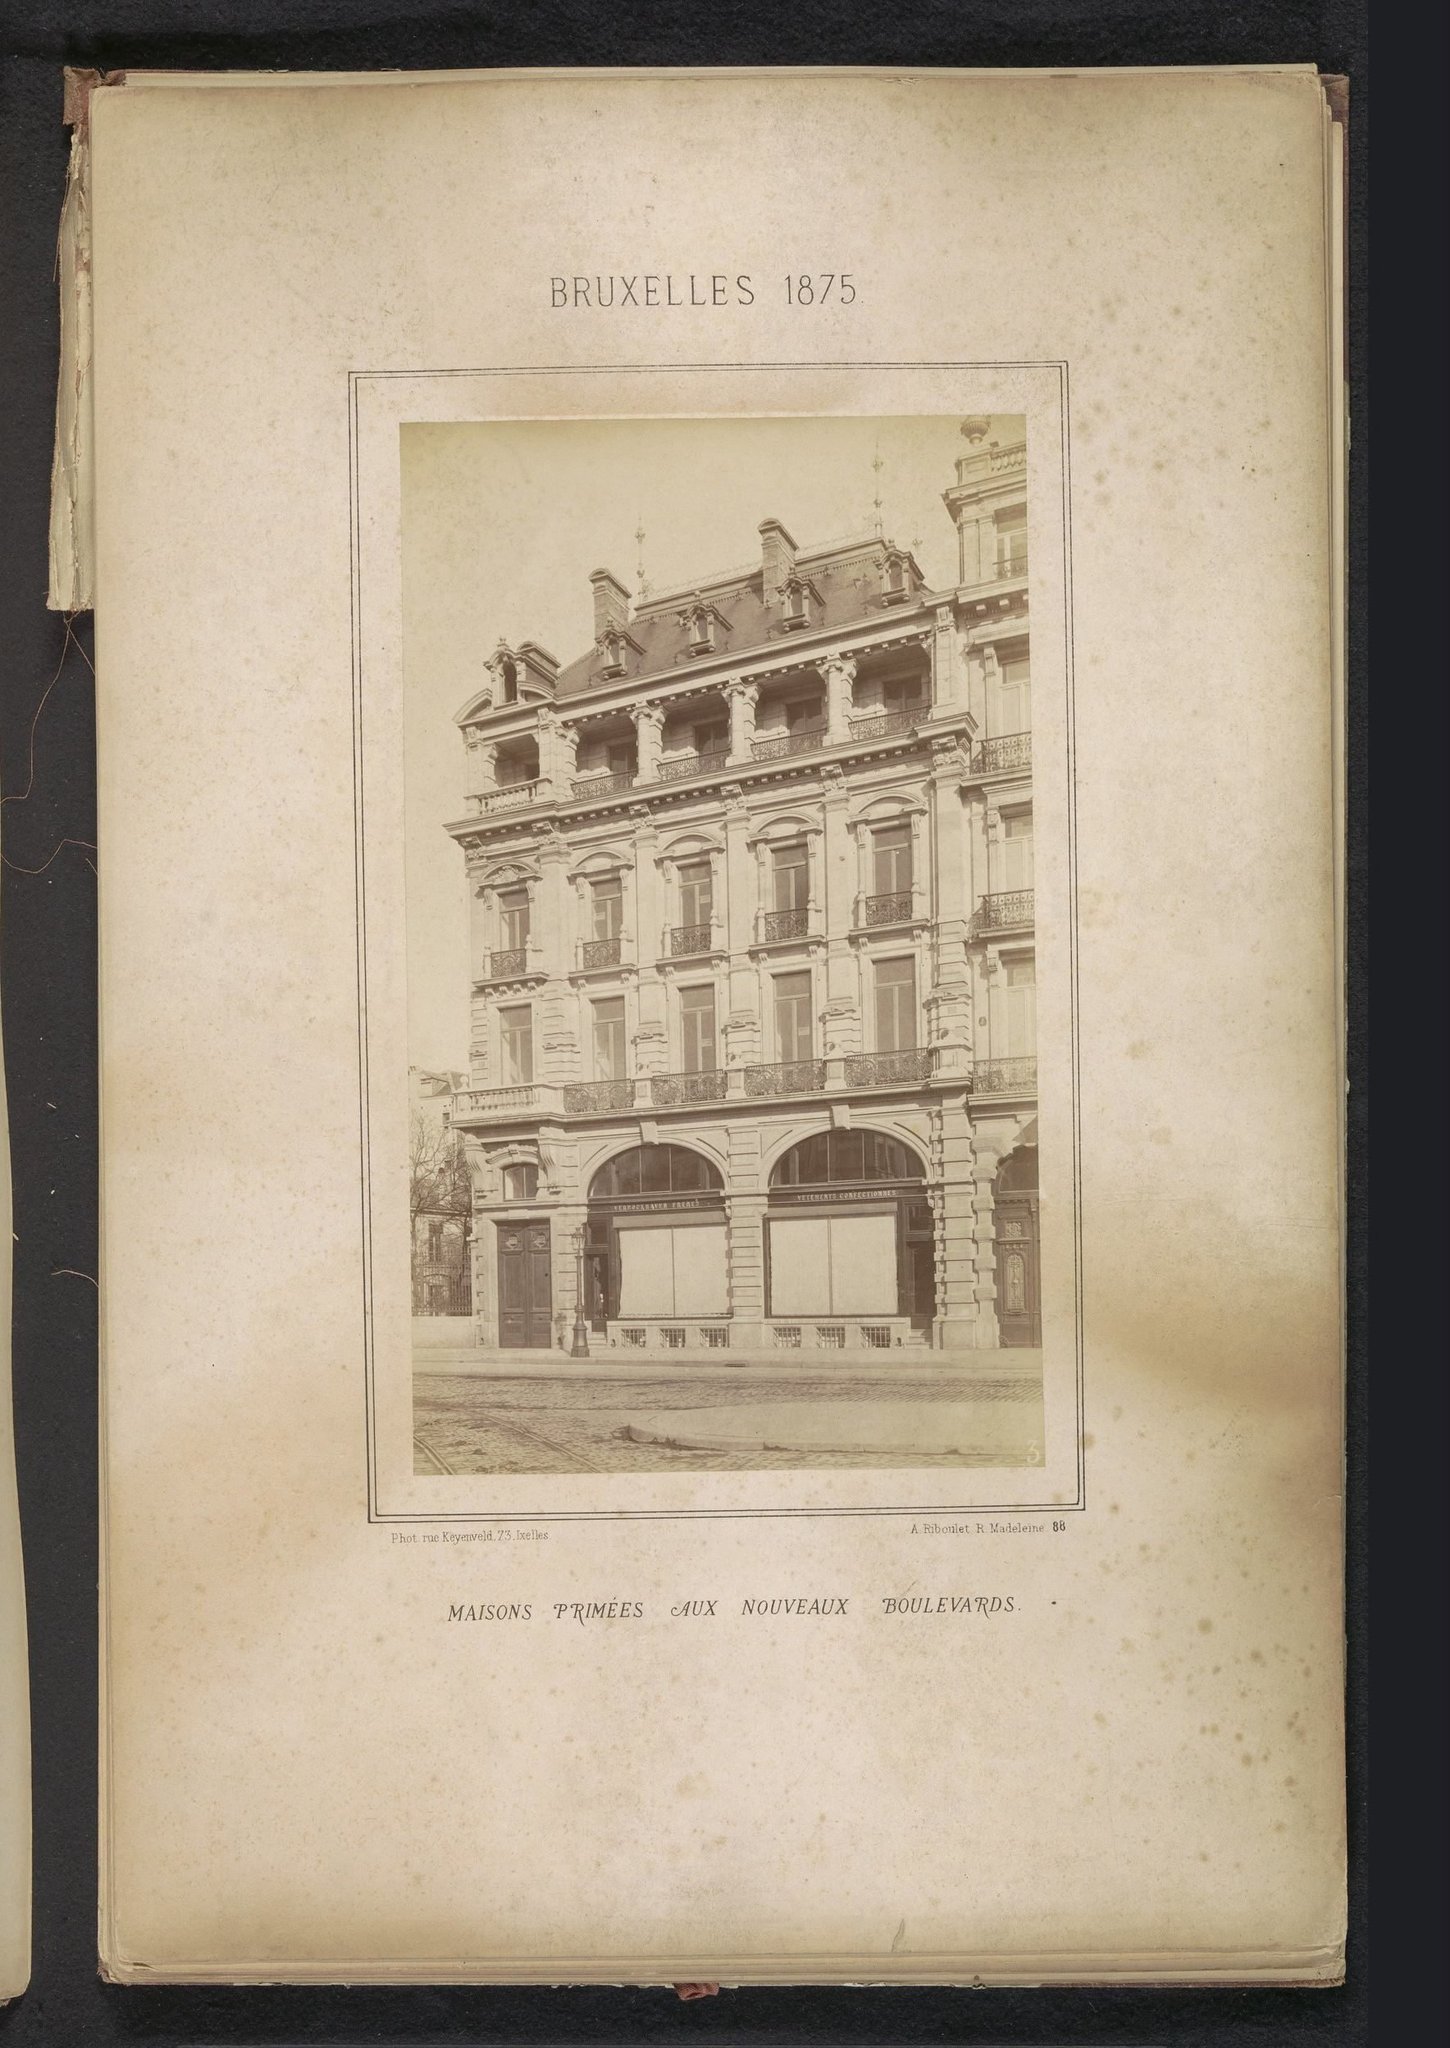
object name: page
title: Exterieur van het gebouw aan Place de Brouckère 19 te Brussel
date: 1875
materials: photographic support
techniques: albumen print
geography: brussels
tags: housing, façade (of house or building)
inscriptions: number: ‘3’